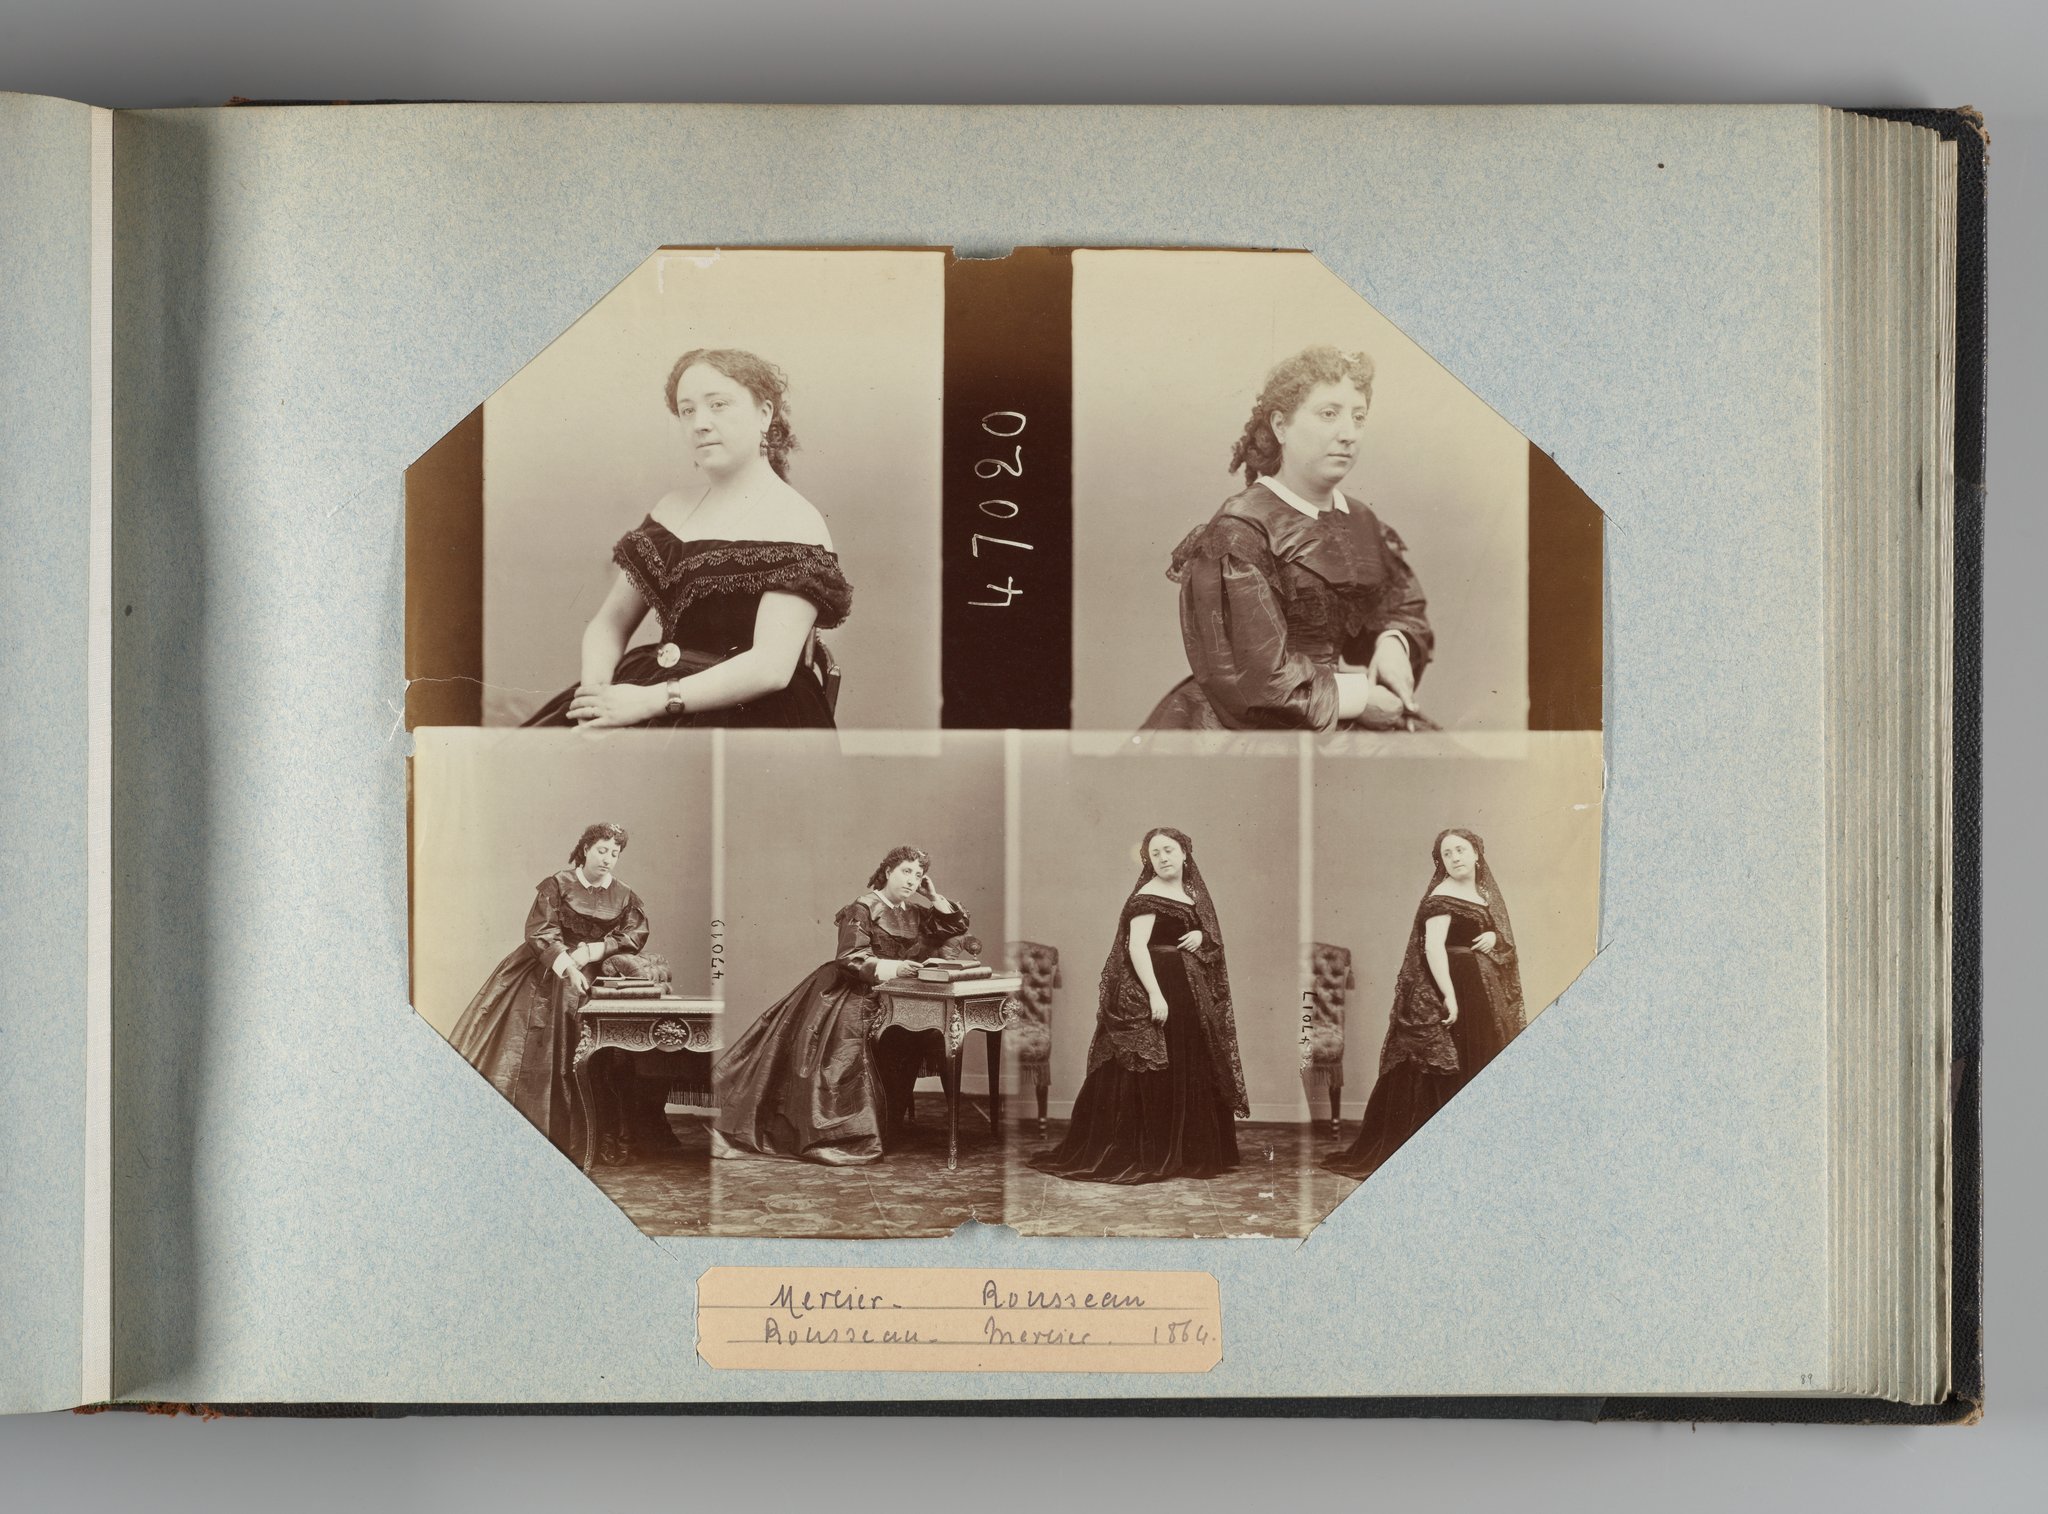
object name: photograph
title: Mlle Mercier; Mlle Rousseau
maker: andré-adolphe-eugène disdéri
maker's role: artist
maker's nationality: french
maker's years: 1819-1889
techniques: albumen silver print, glass negative